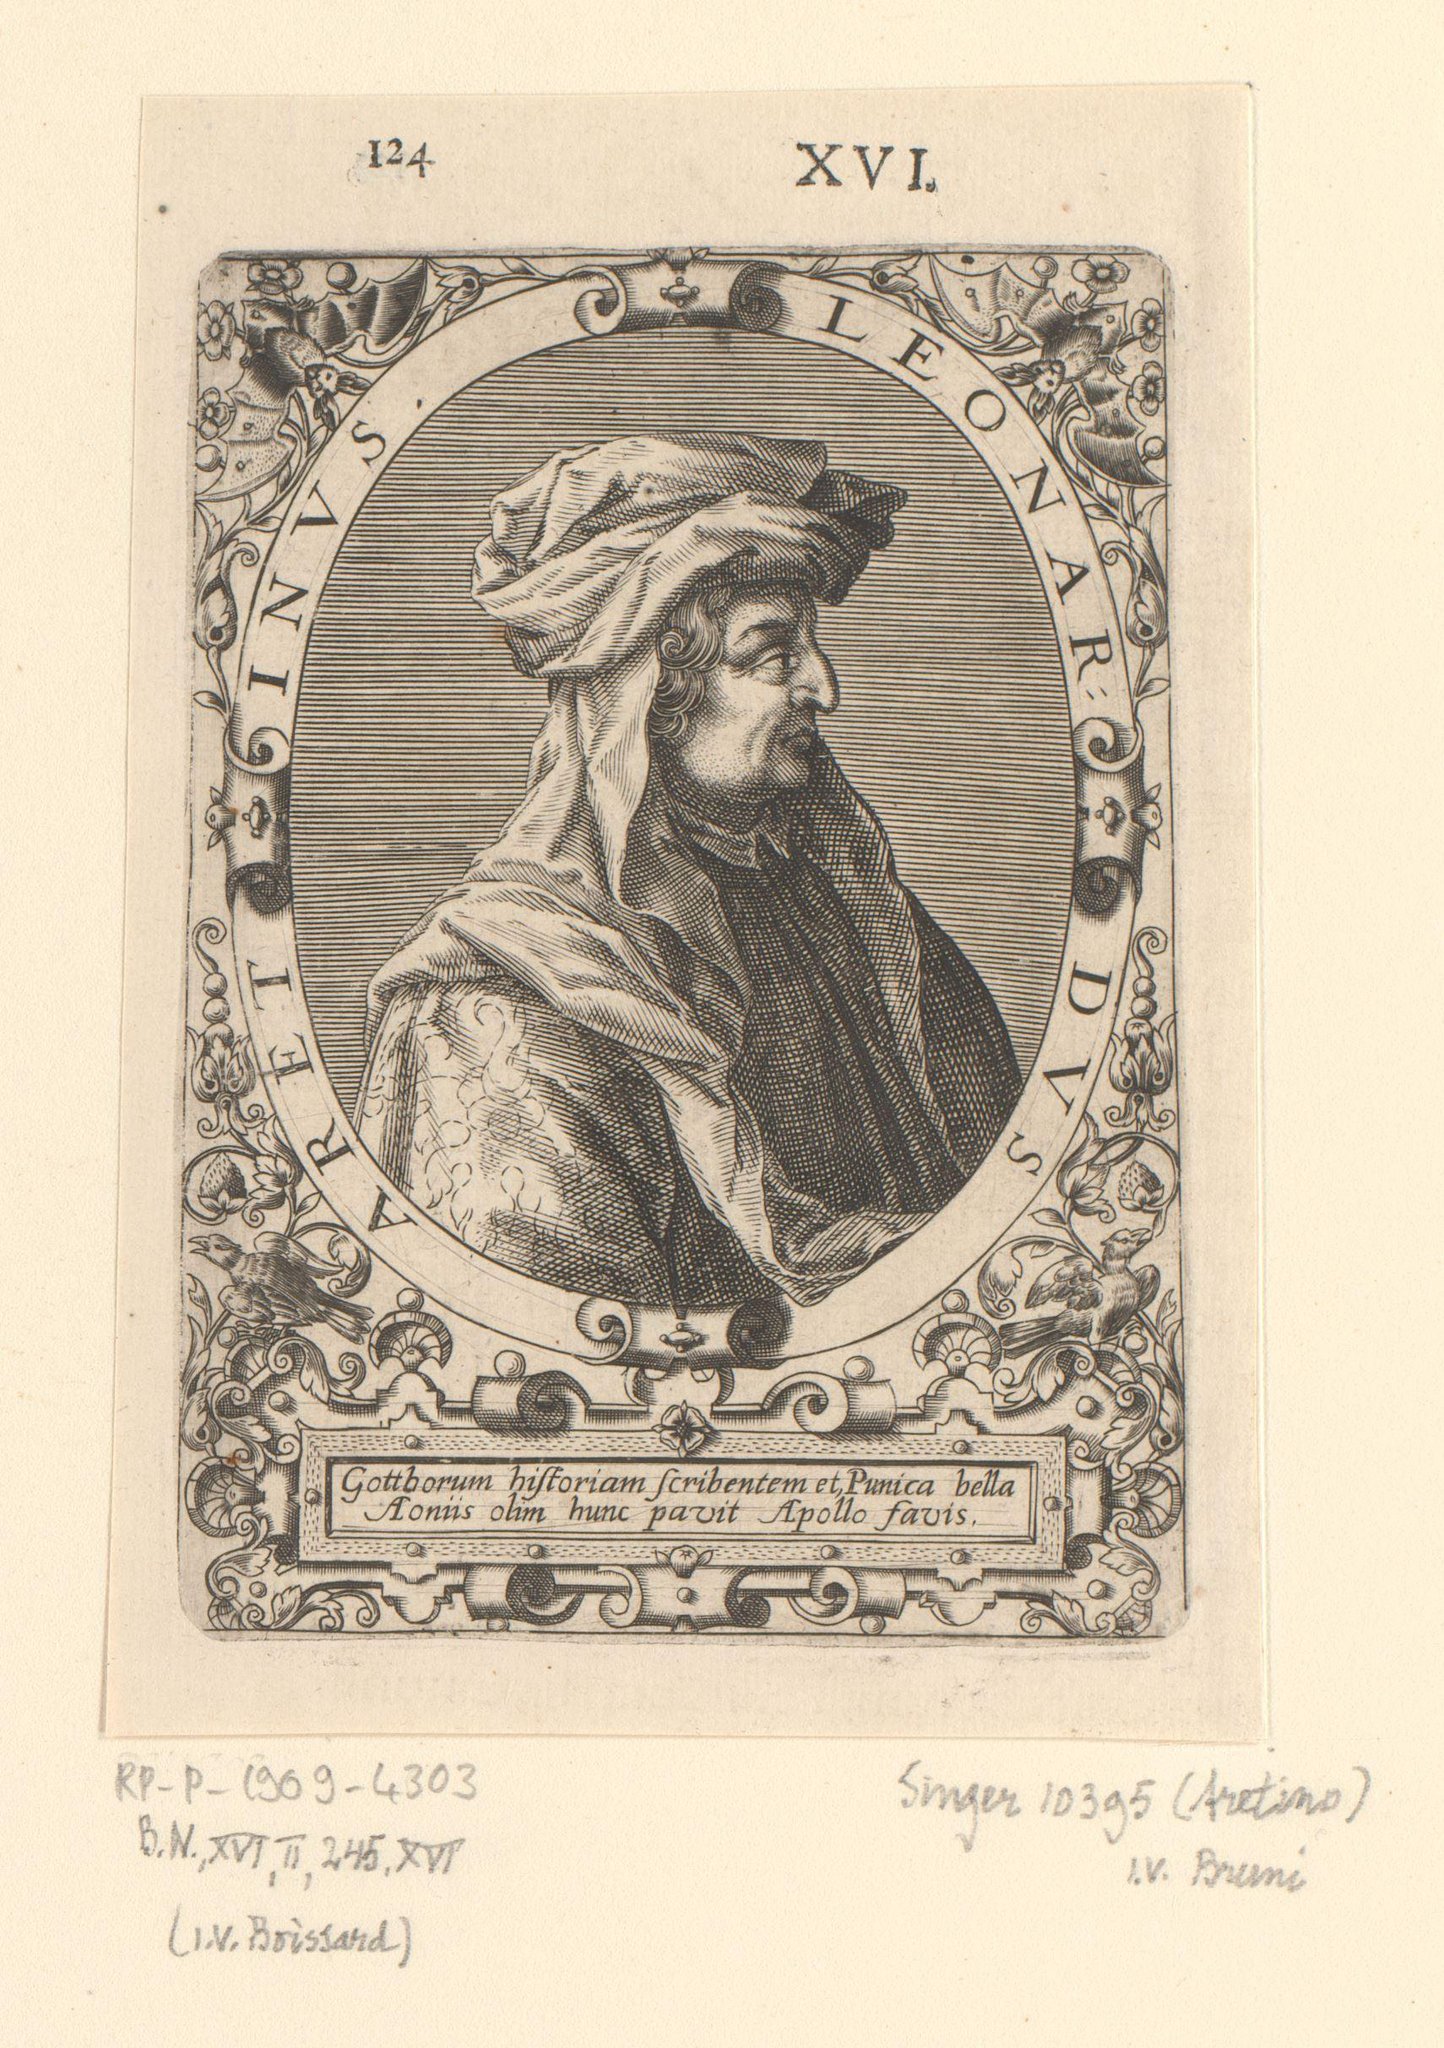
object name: print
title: Leonardvs Aretinvs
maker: jean jacques boissard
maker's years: 1528-1598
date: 1597-1599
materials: paper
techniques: engraving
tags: arezzo, florence, historicus, geleerde, leonardo bruni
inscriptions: collector's mark: Lugt 2228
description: Portret van de Italiaanse humanist Leonardo Bruni in ovaal met randschrift. In een sierlijst met vleermuizen en vogels en met een cartouche met een Latijns vers.